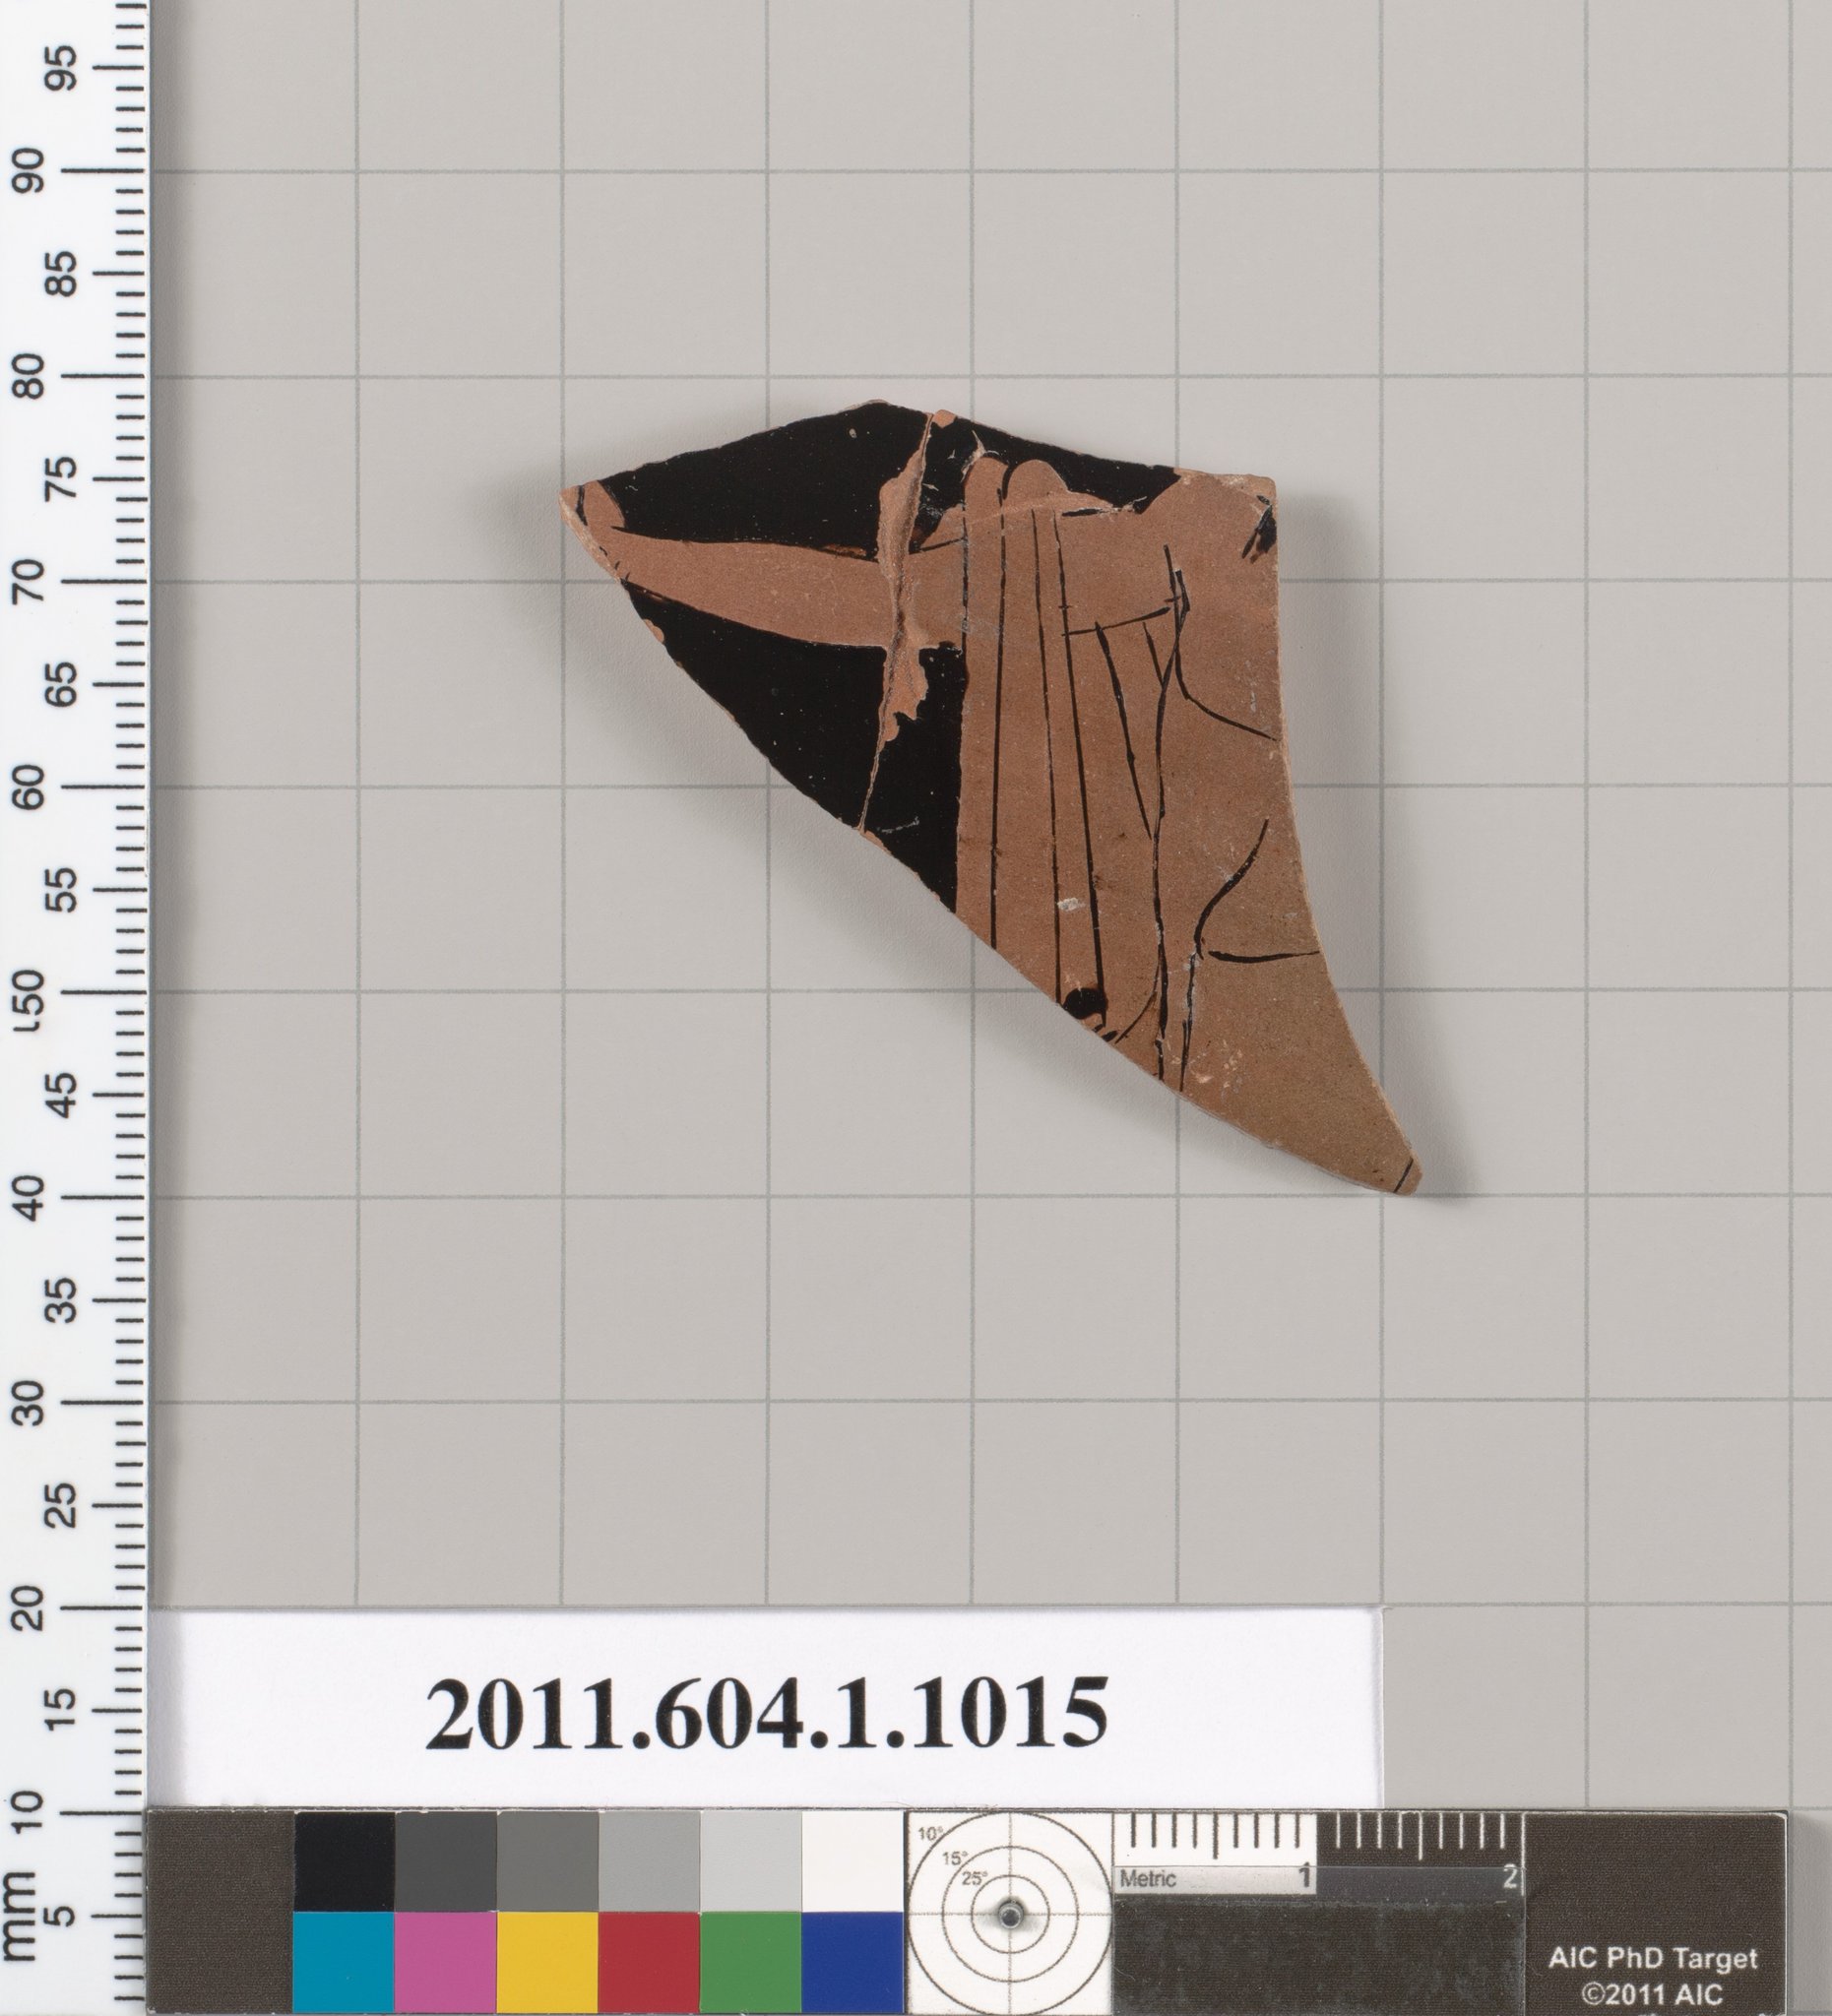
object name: kylix fragment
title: Terracotta fragment of a kylix (drinking cup)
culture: greek, attic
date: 475-451 BCE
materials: terracotta